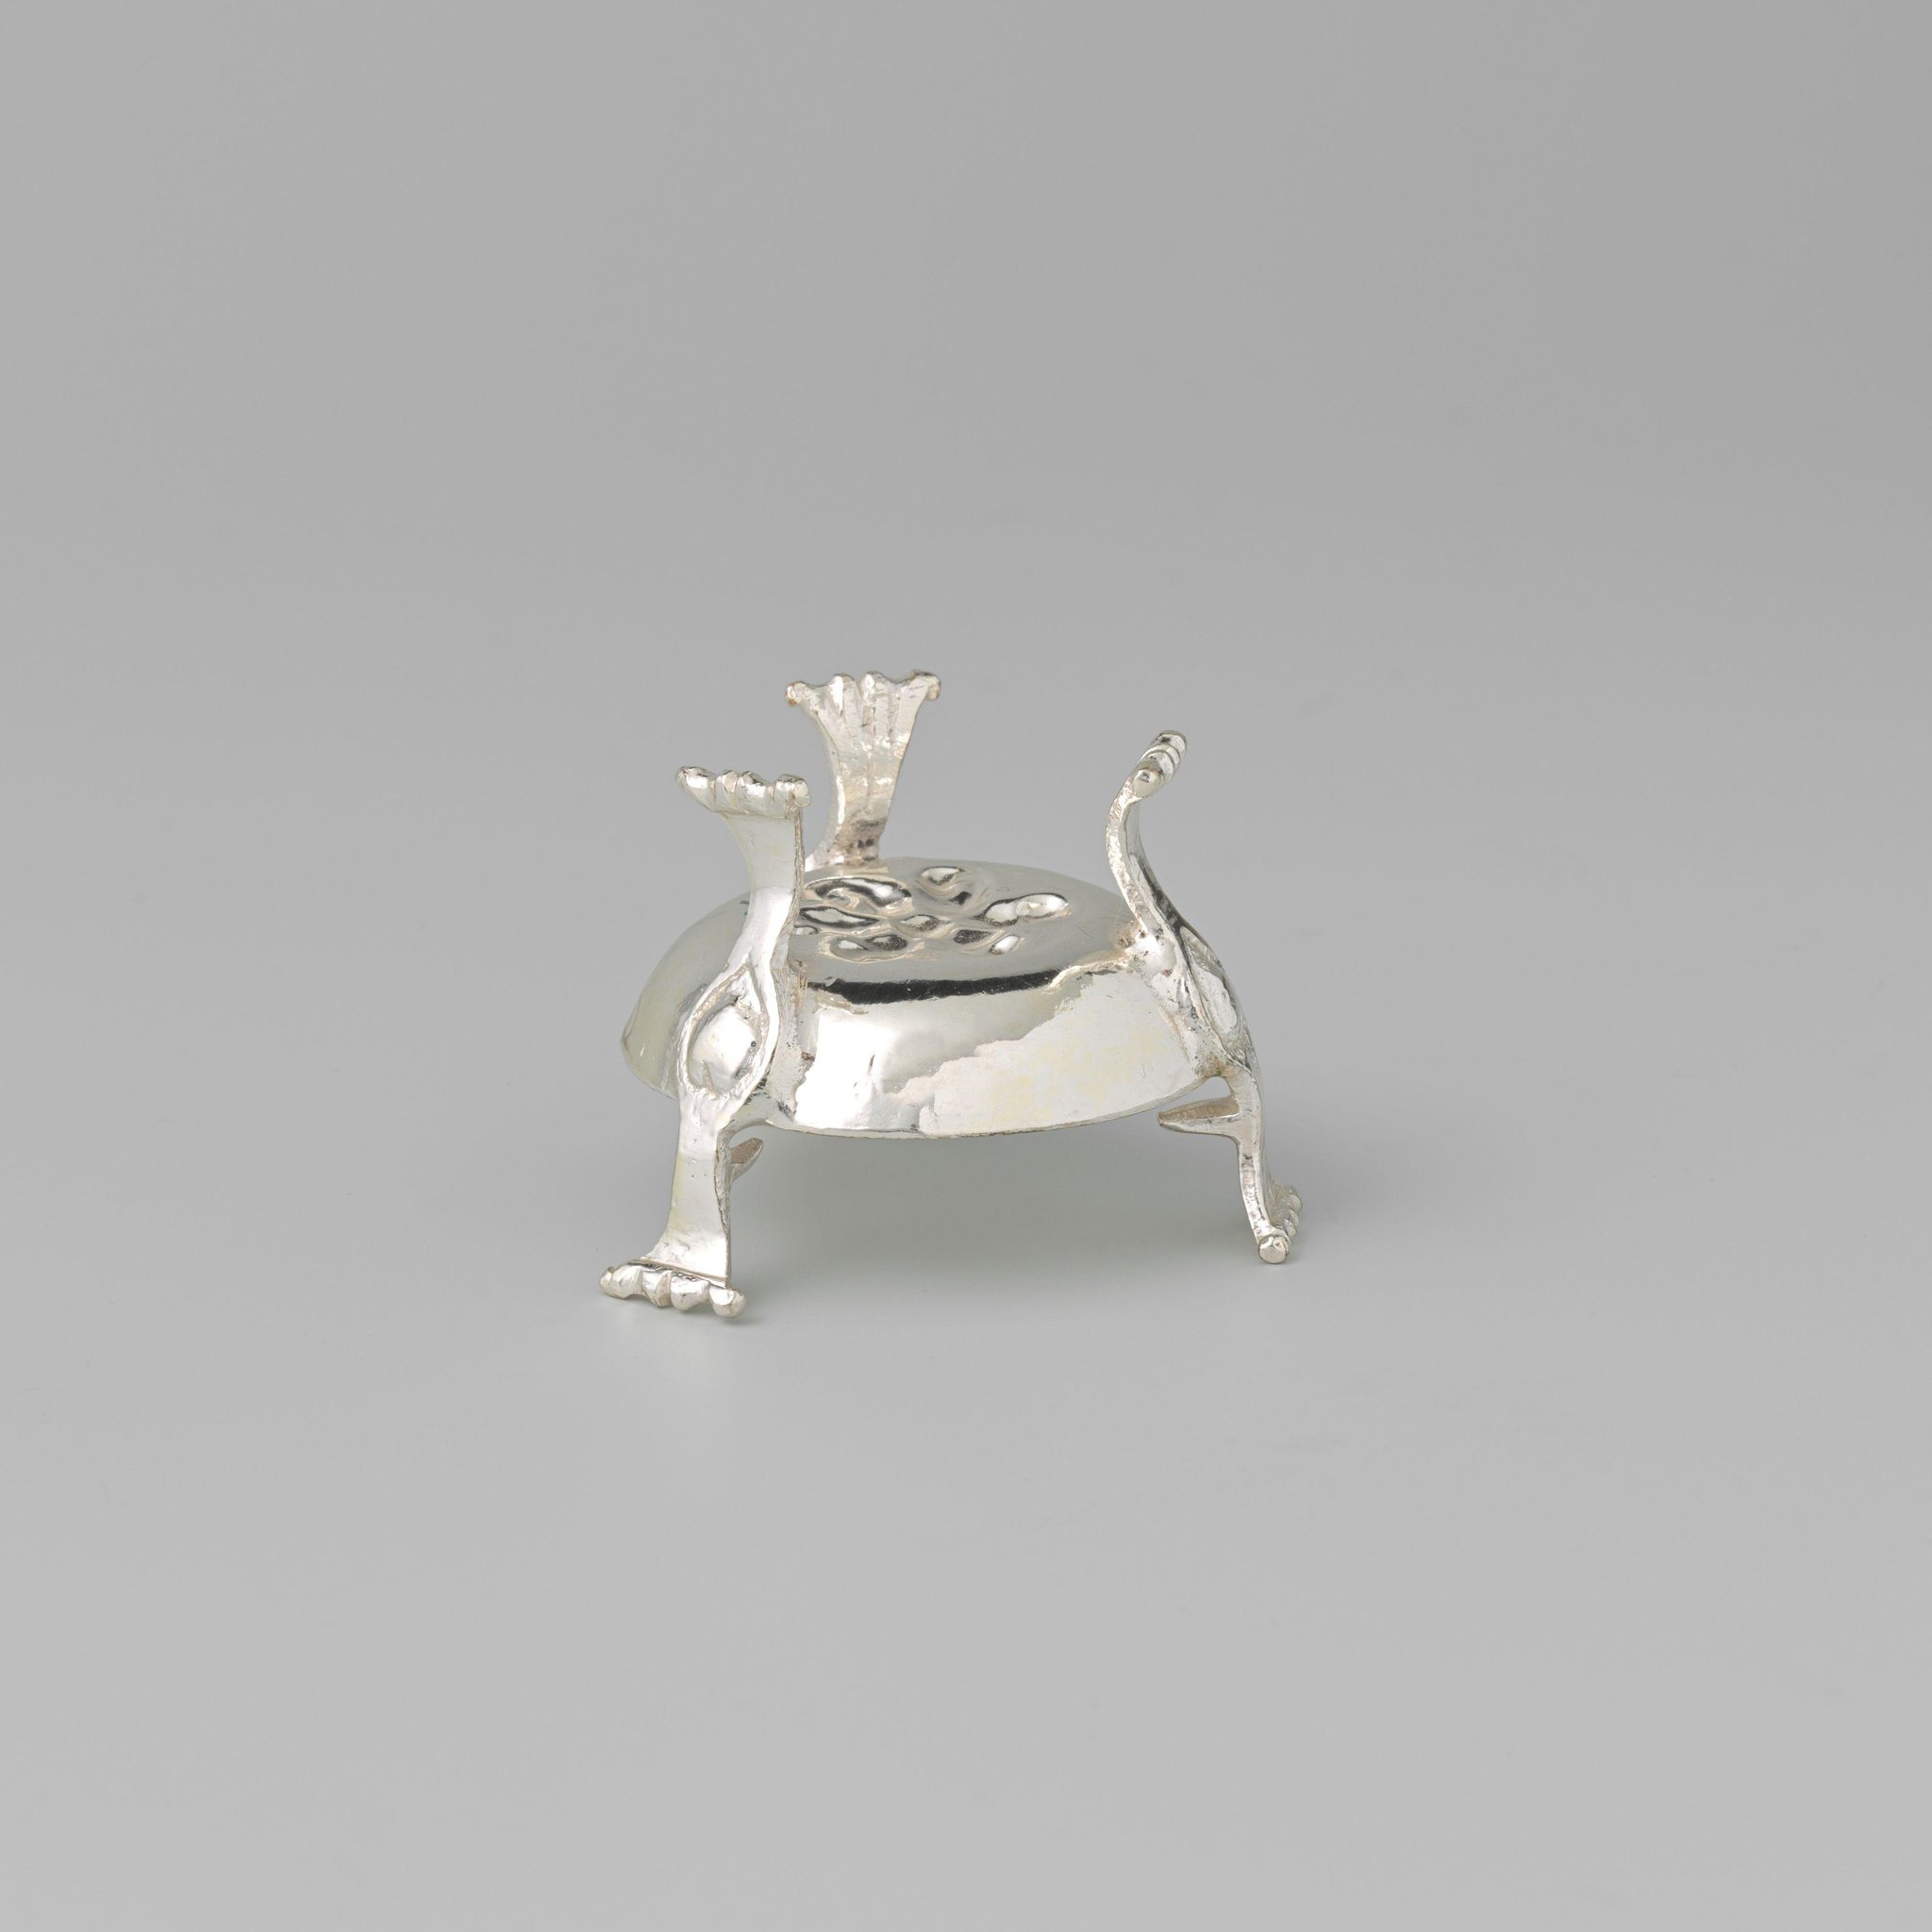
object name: komfoor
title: Komfoor van zilver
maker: cornelis coutrier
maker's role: silversmith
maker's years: 1702-1749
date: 1730-1749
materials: silver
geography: amsterdam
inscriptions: maker's mark: ‘(Citroen, 1030)’, town mark: ‘Amsterdam’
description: Komfoor van zilver, ronde bak met roset van zes bladeren in de bodem, gevat tussen drie pootjes die op de plaats van aanhechting een hart in reliëf hebben.